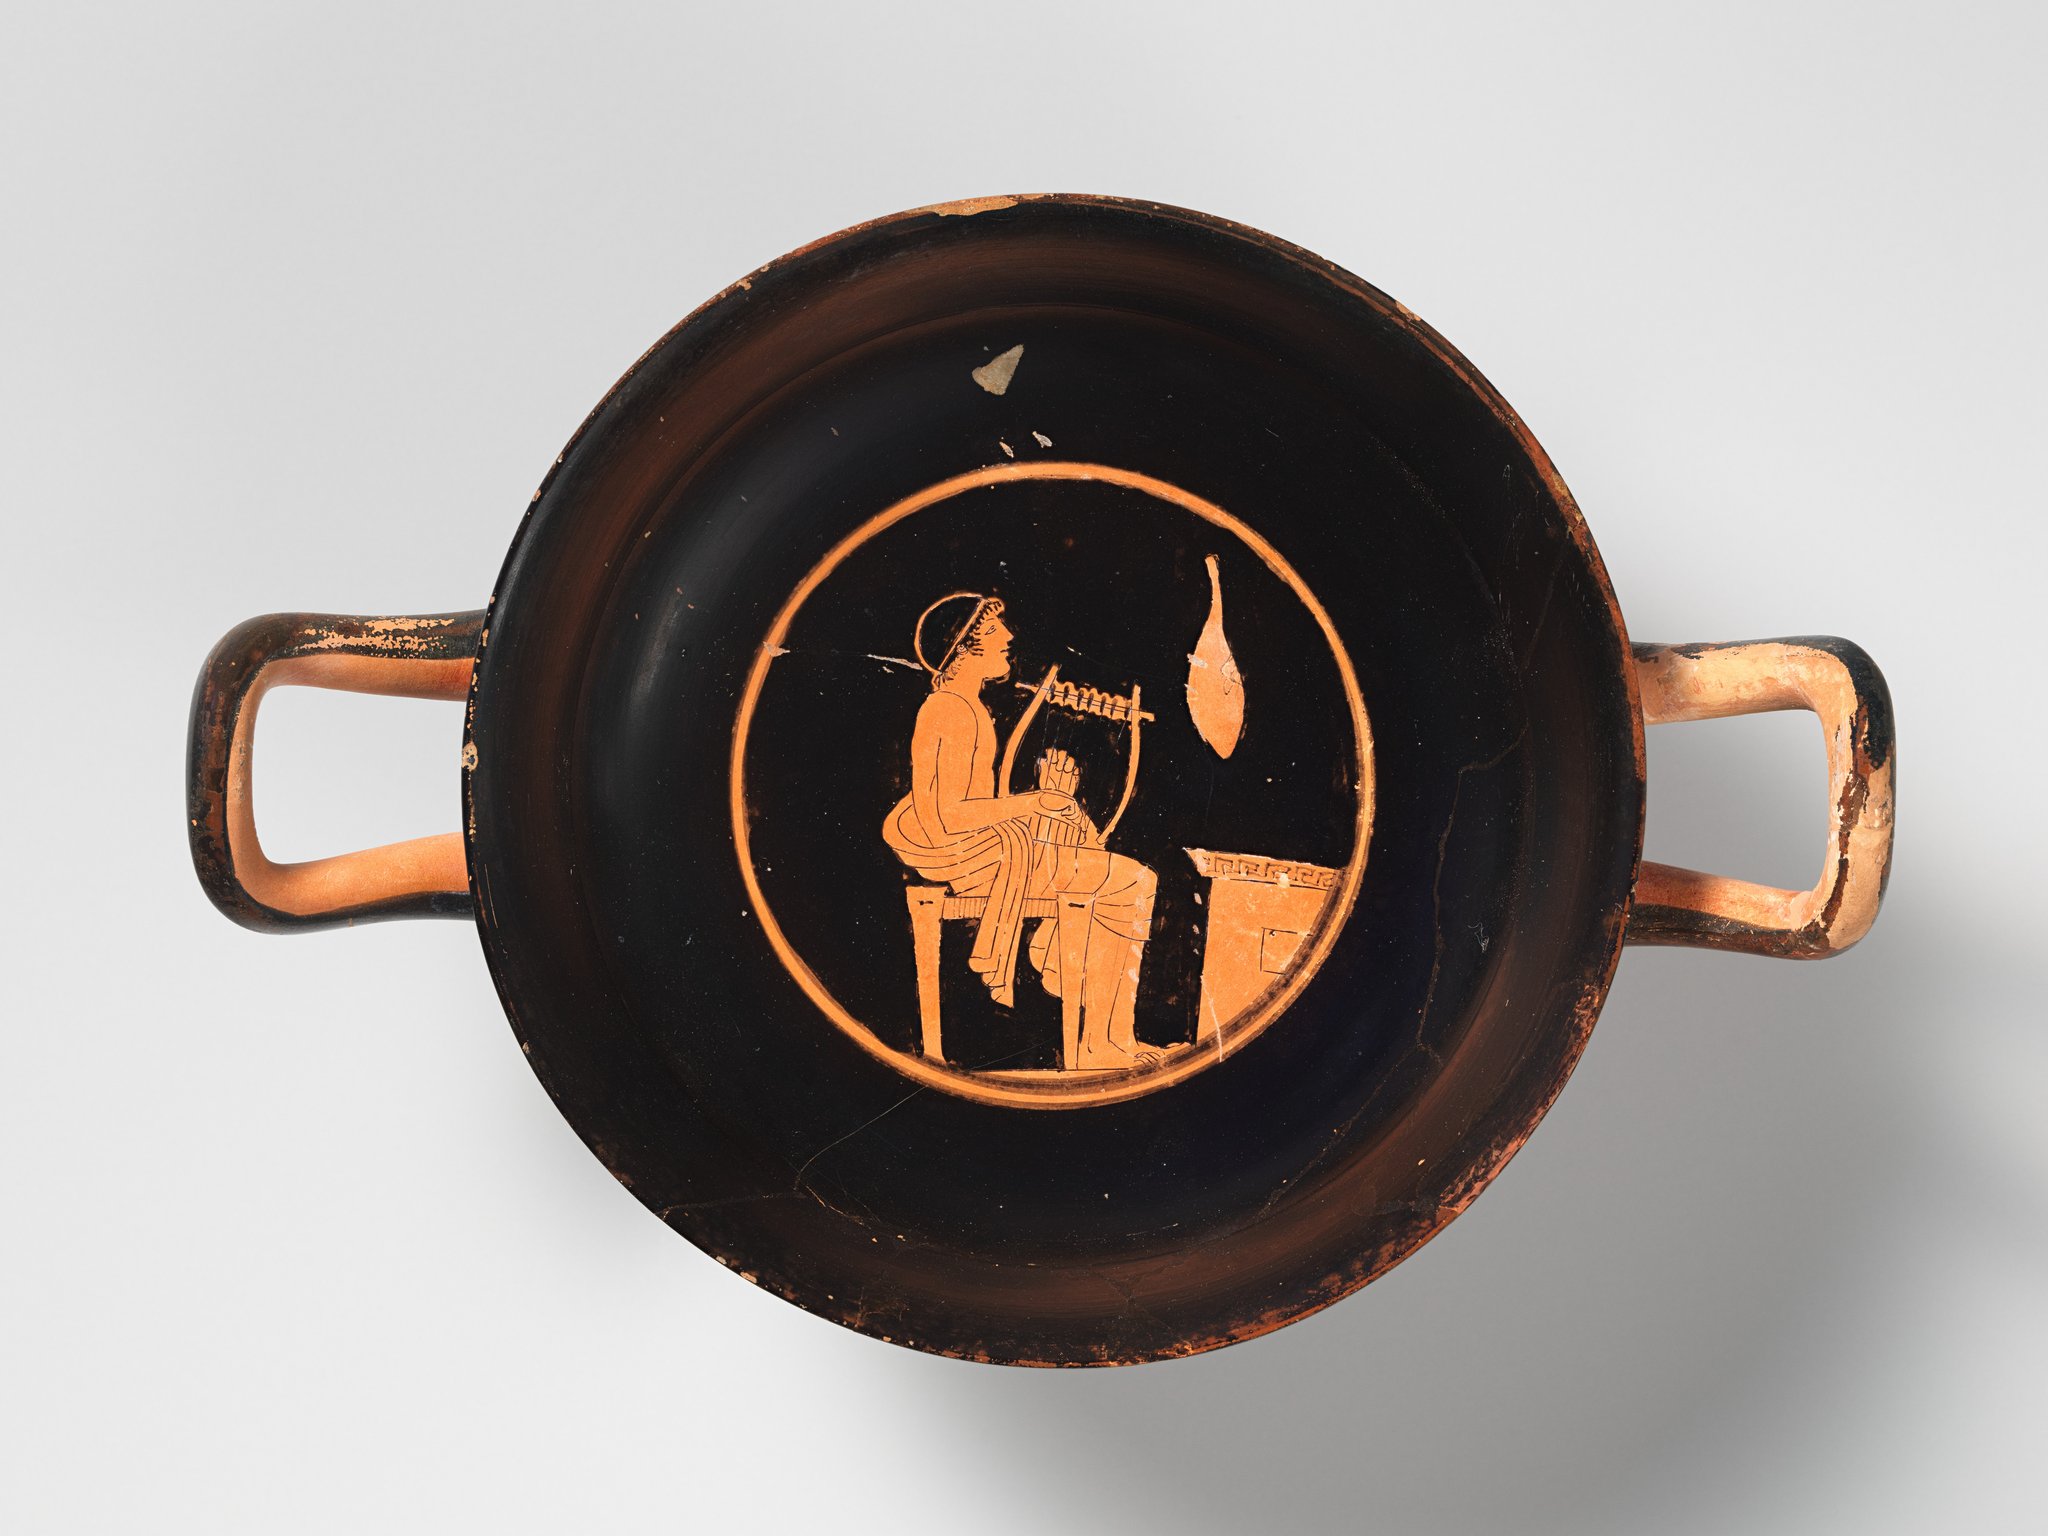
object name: kylix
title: Terracotta kylix (drinking cup)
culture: greek, attic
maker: akestorides painter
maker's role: artist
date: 460 BCE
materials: terracotta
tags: musical instruments,men,lyres